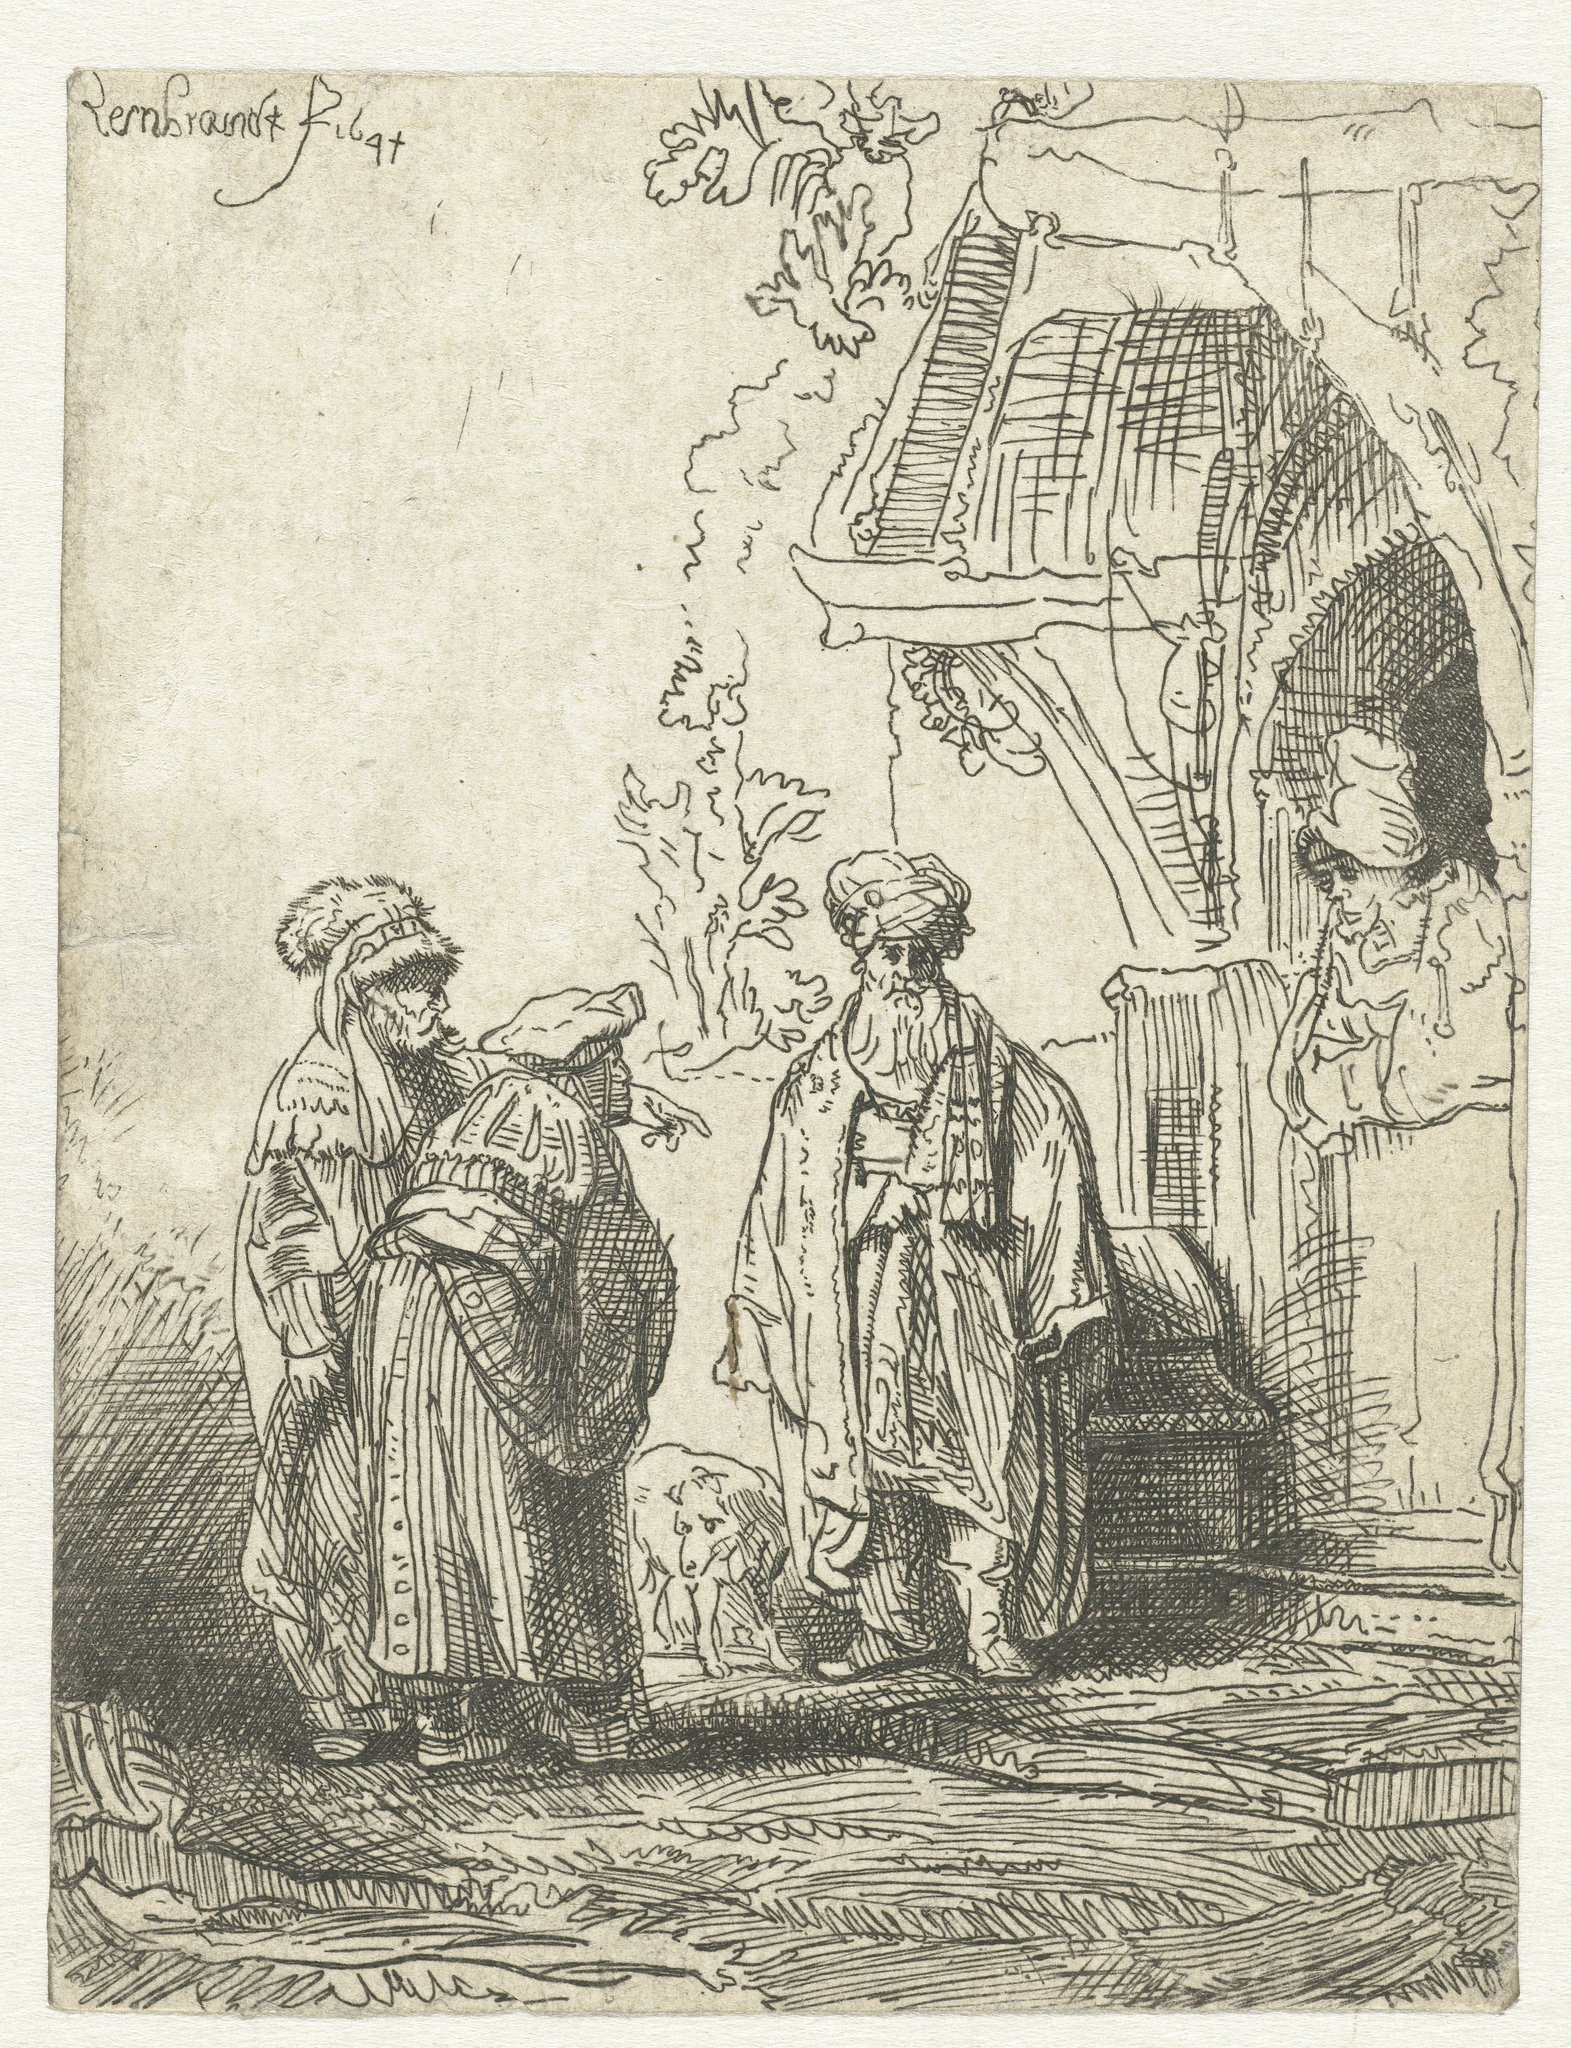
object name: print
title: Three oriental figures (Jacob and Laban?)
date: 1816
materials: paper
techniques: etching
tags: the partnership with laban ~ story of jacob (genesis 30:25-43)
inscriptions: collector's mark: Lugt 2228, collector's mark: Lugt 2760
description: Spiegelbeeldige kopie naar de gelijknamige prent van Rembrandt. Prent gebruikt in: A collection of 200 original etchings. Londen: J.M. Creery, [1816].